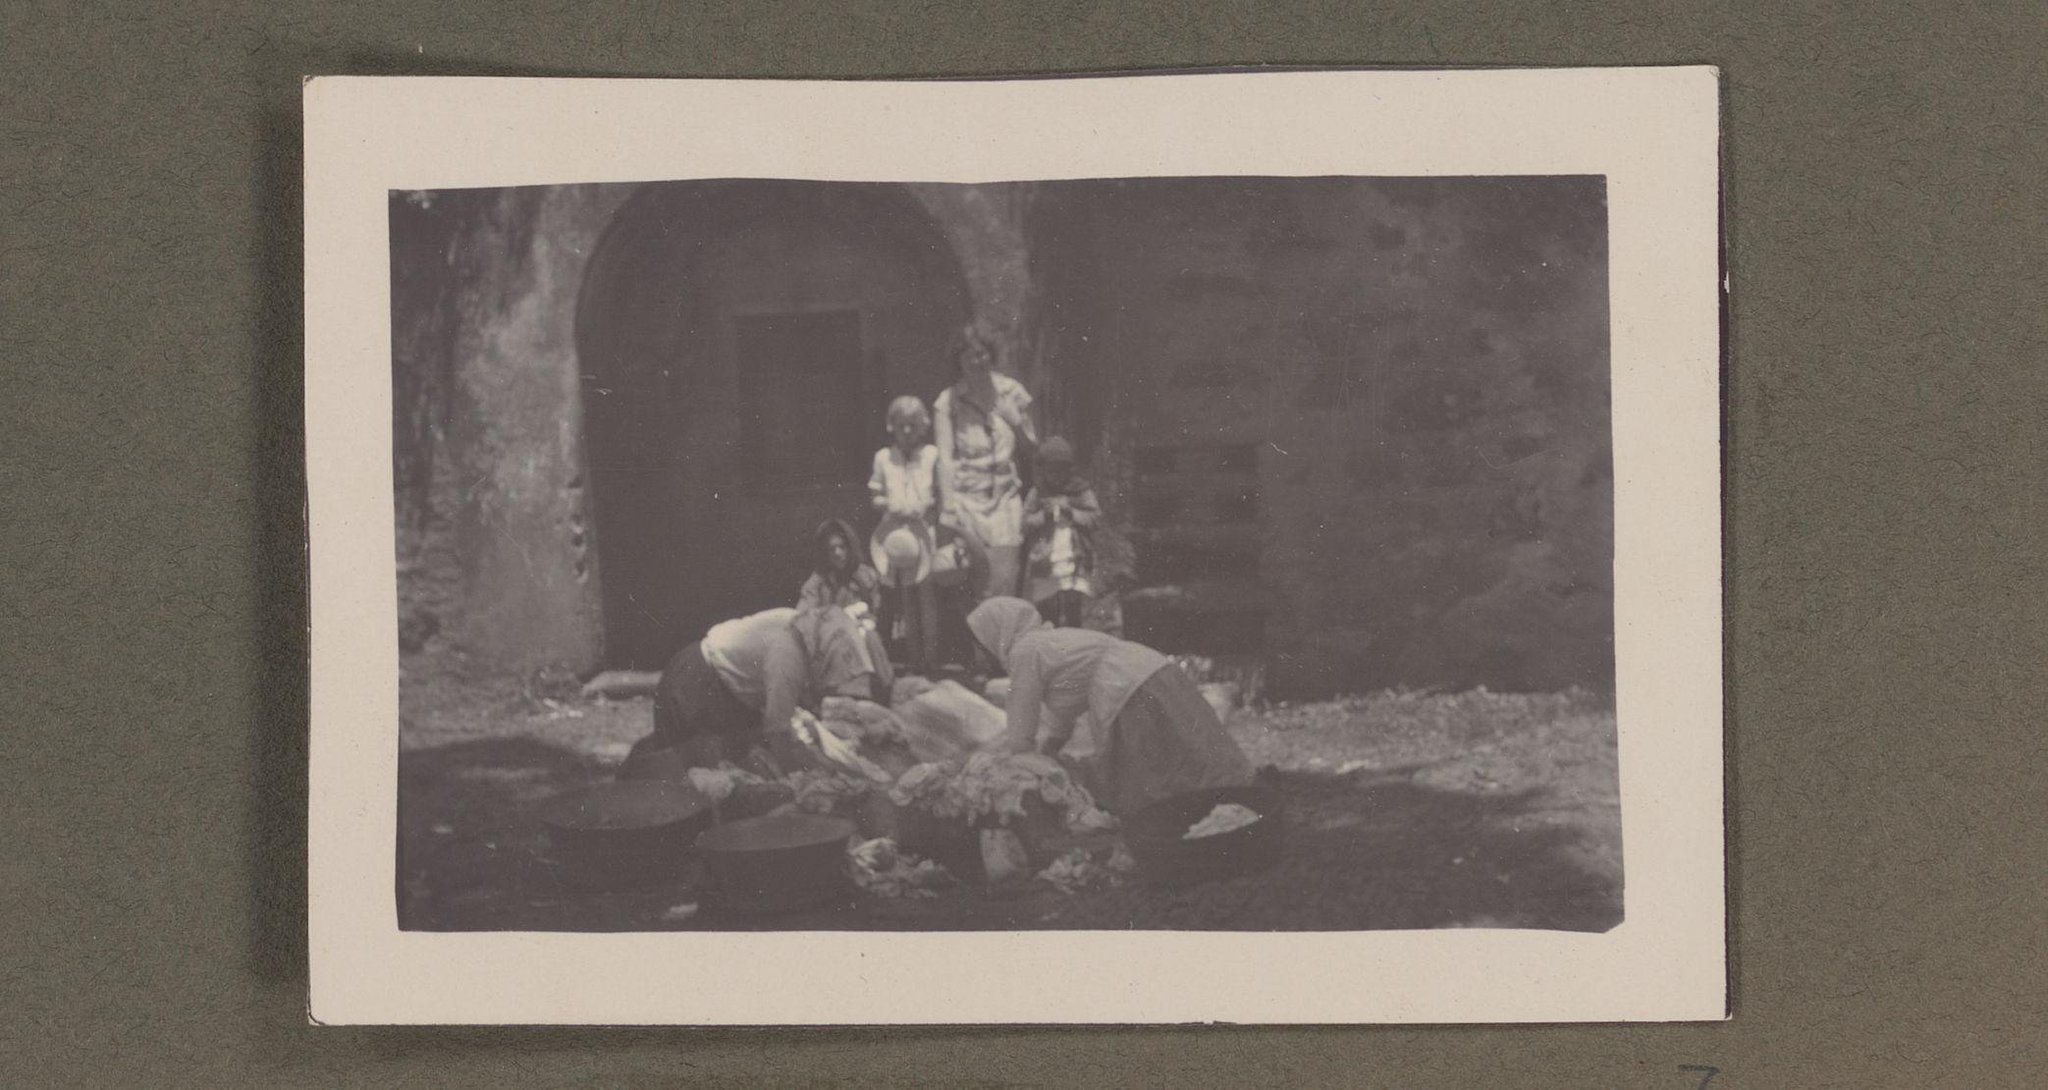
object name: photograph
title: Bezoek aan Madeira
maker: Anonymous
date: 1925-1927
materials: photographic support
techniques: photography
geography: suriname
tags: jetten, familie, moengo, madeira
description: Bezoek aan Madeira, bij vrouwen die de was doen. Foto op een bladzijde van een los albumblad. Onderdeel van het ensemble met foto's van de familie van ingenieur Jetten in de mijnbouwstad Moengo in Suriname.